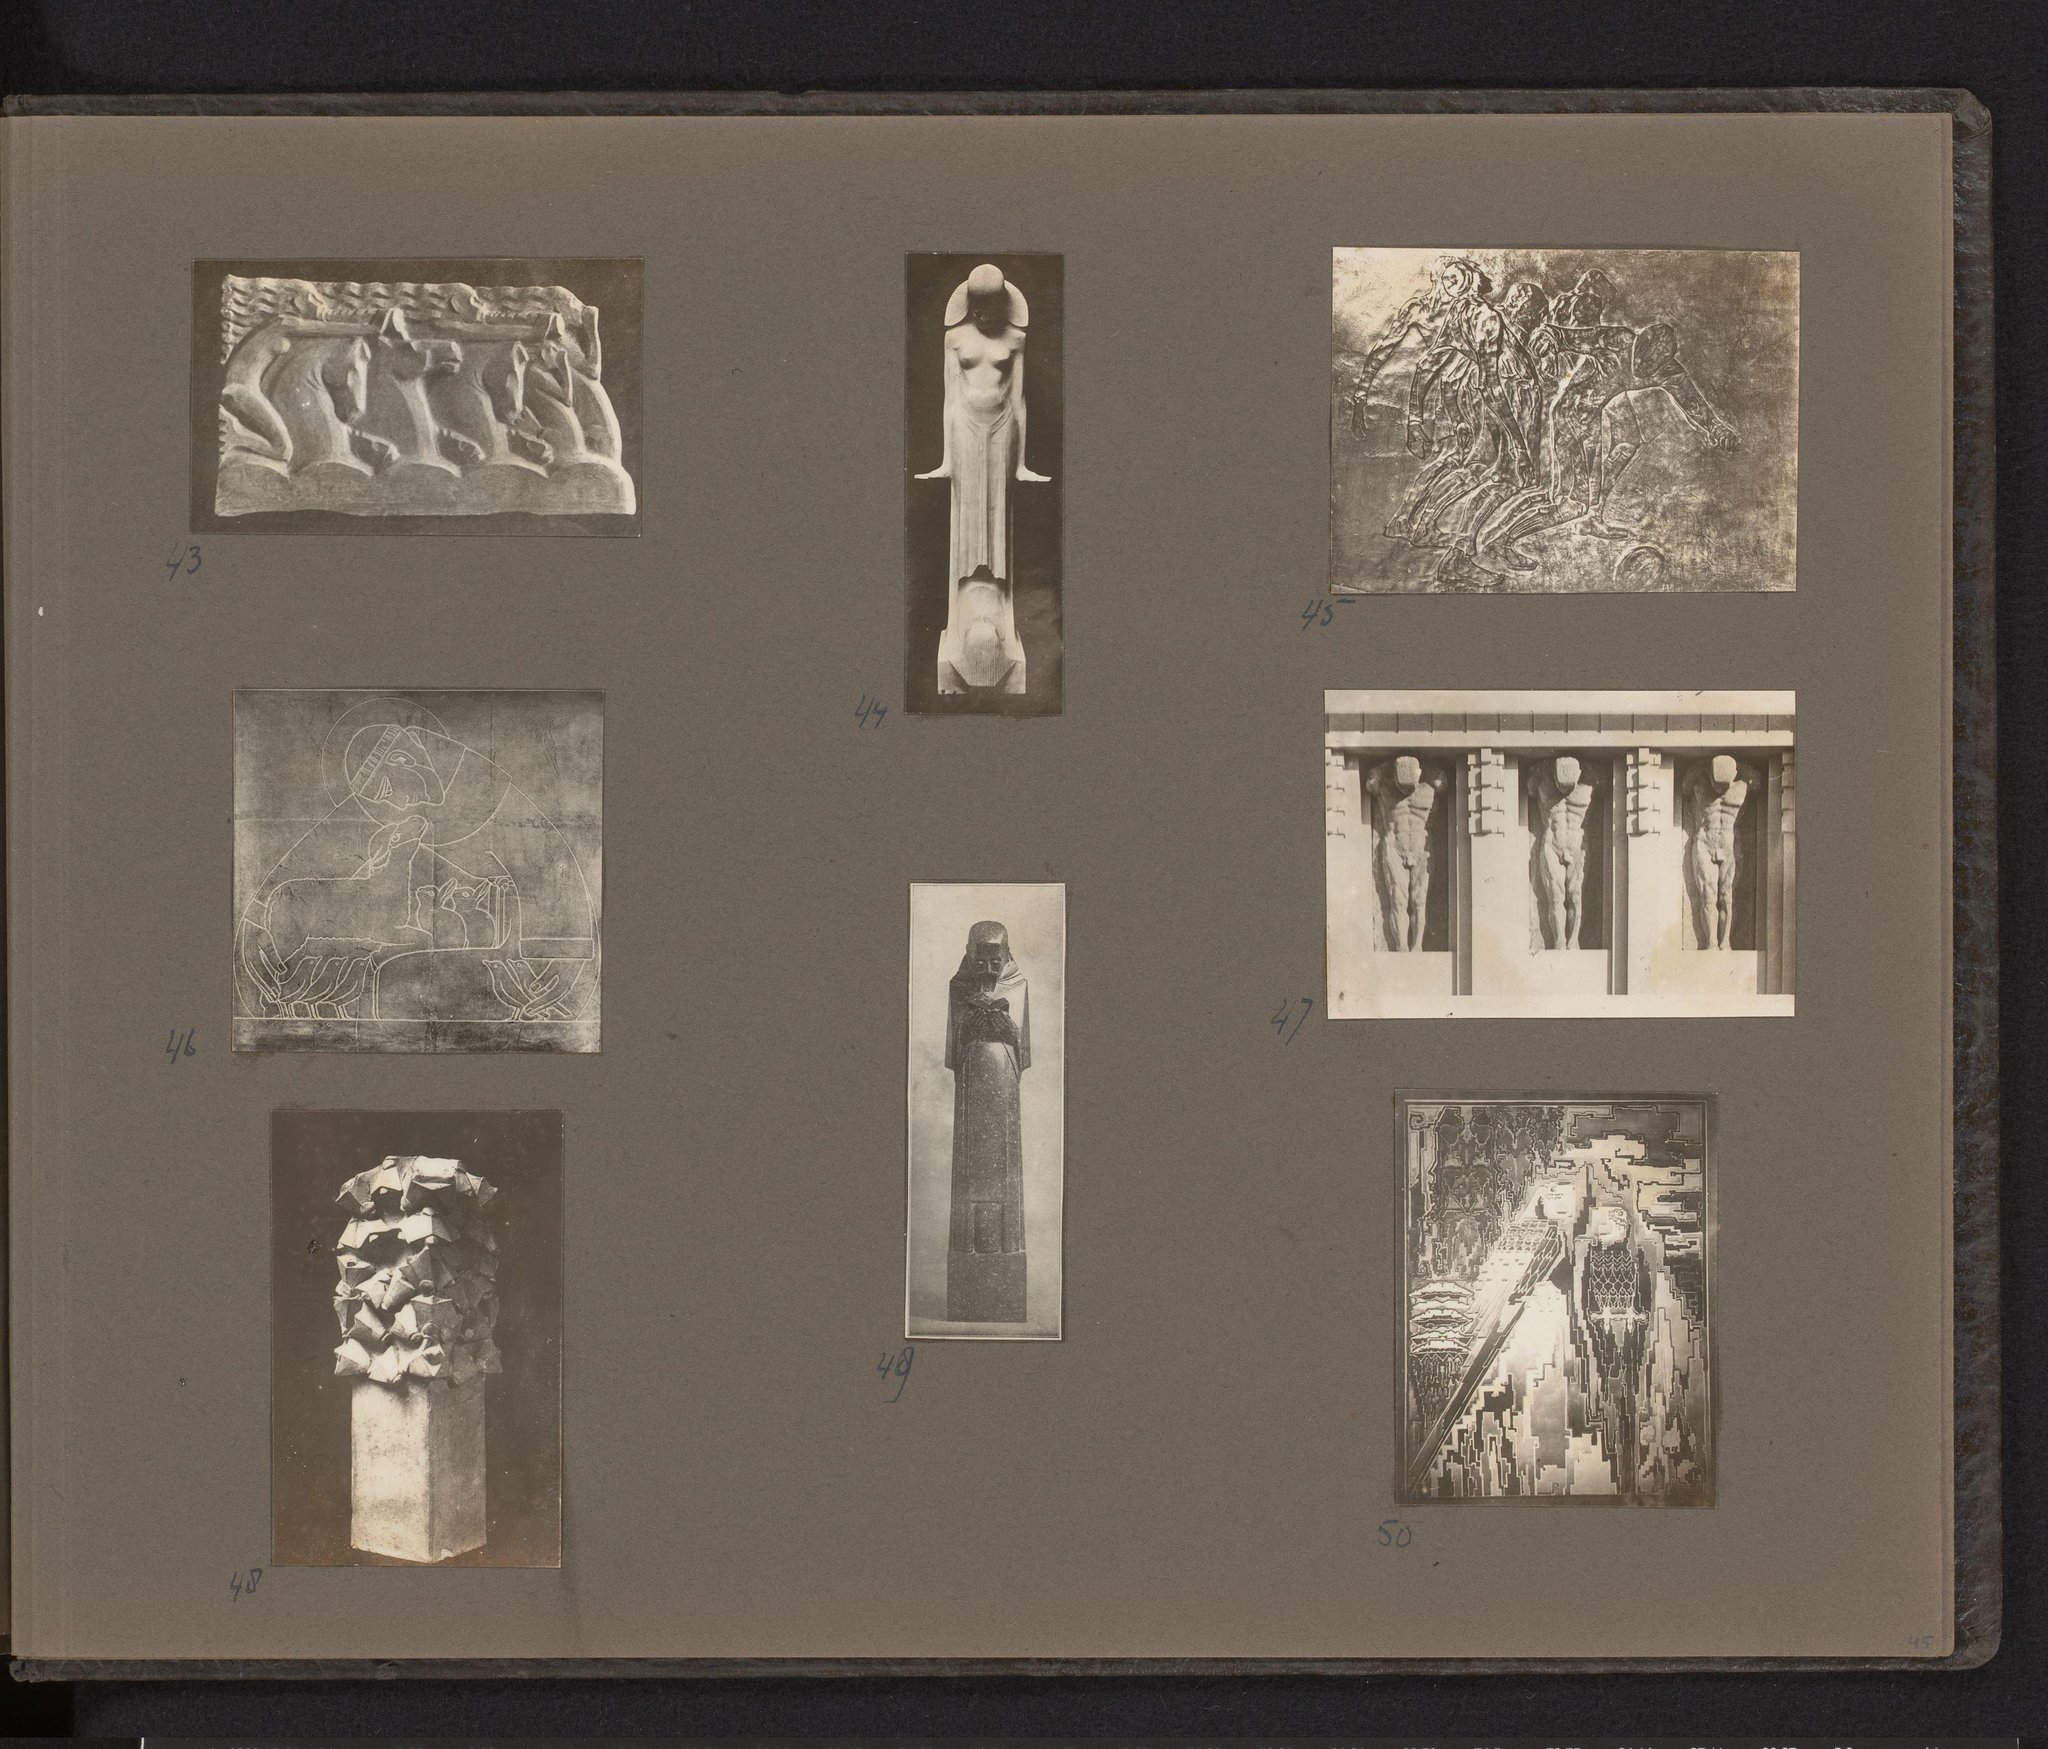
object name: album leaf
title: Drie sculpturen, vier reliëfs en een paneel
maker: Anonymous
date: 1920-1940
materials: paper, photographic support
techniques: gelatin silver print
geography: netherlands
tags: adult woman, adult man, saints, piece of sculpture, reproduction of a piece of sculpture, sculpture (+ relief ~ sculpture)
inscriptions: number: ‘43 - 44 - 45/ 46 - 47/ 49/ 48 - 50’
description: Afgebeeld zijn sculpturen van een vrouw, een man en een abstract geheel. Op de reliëfs zijn mannen te paard, een heilige met lam, konijnen en vogels en mannen afgebeeld. Deze foto's maken deel uit van een album.